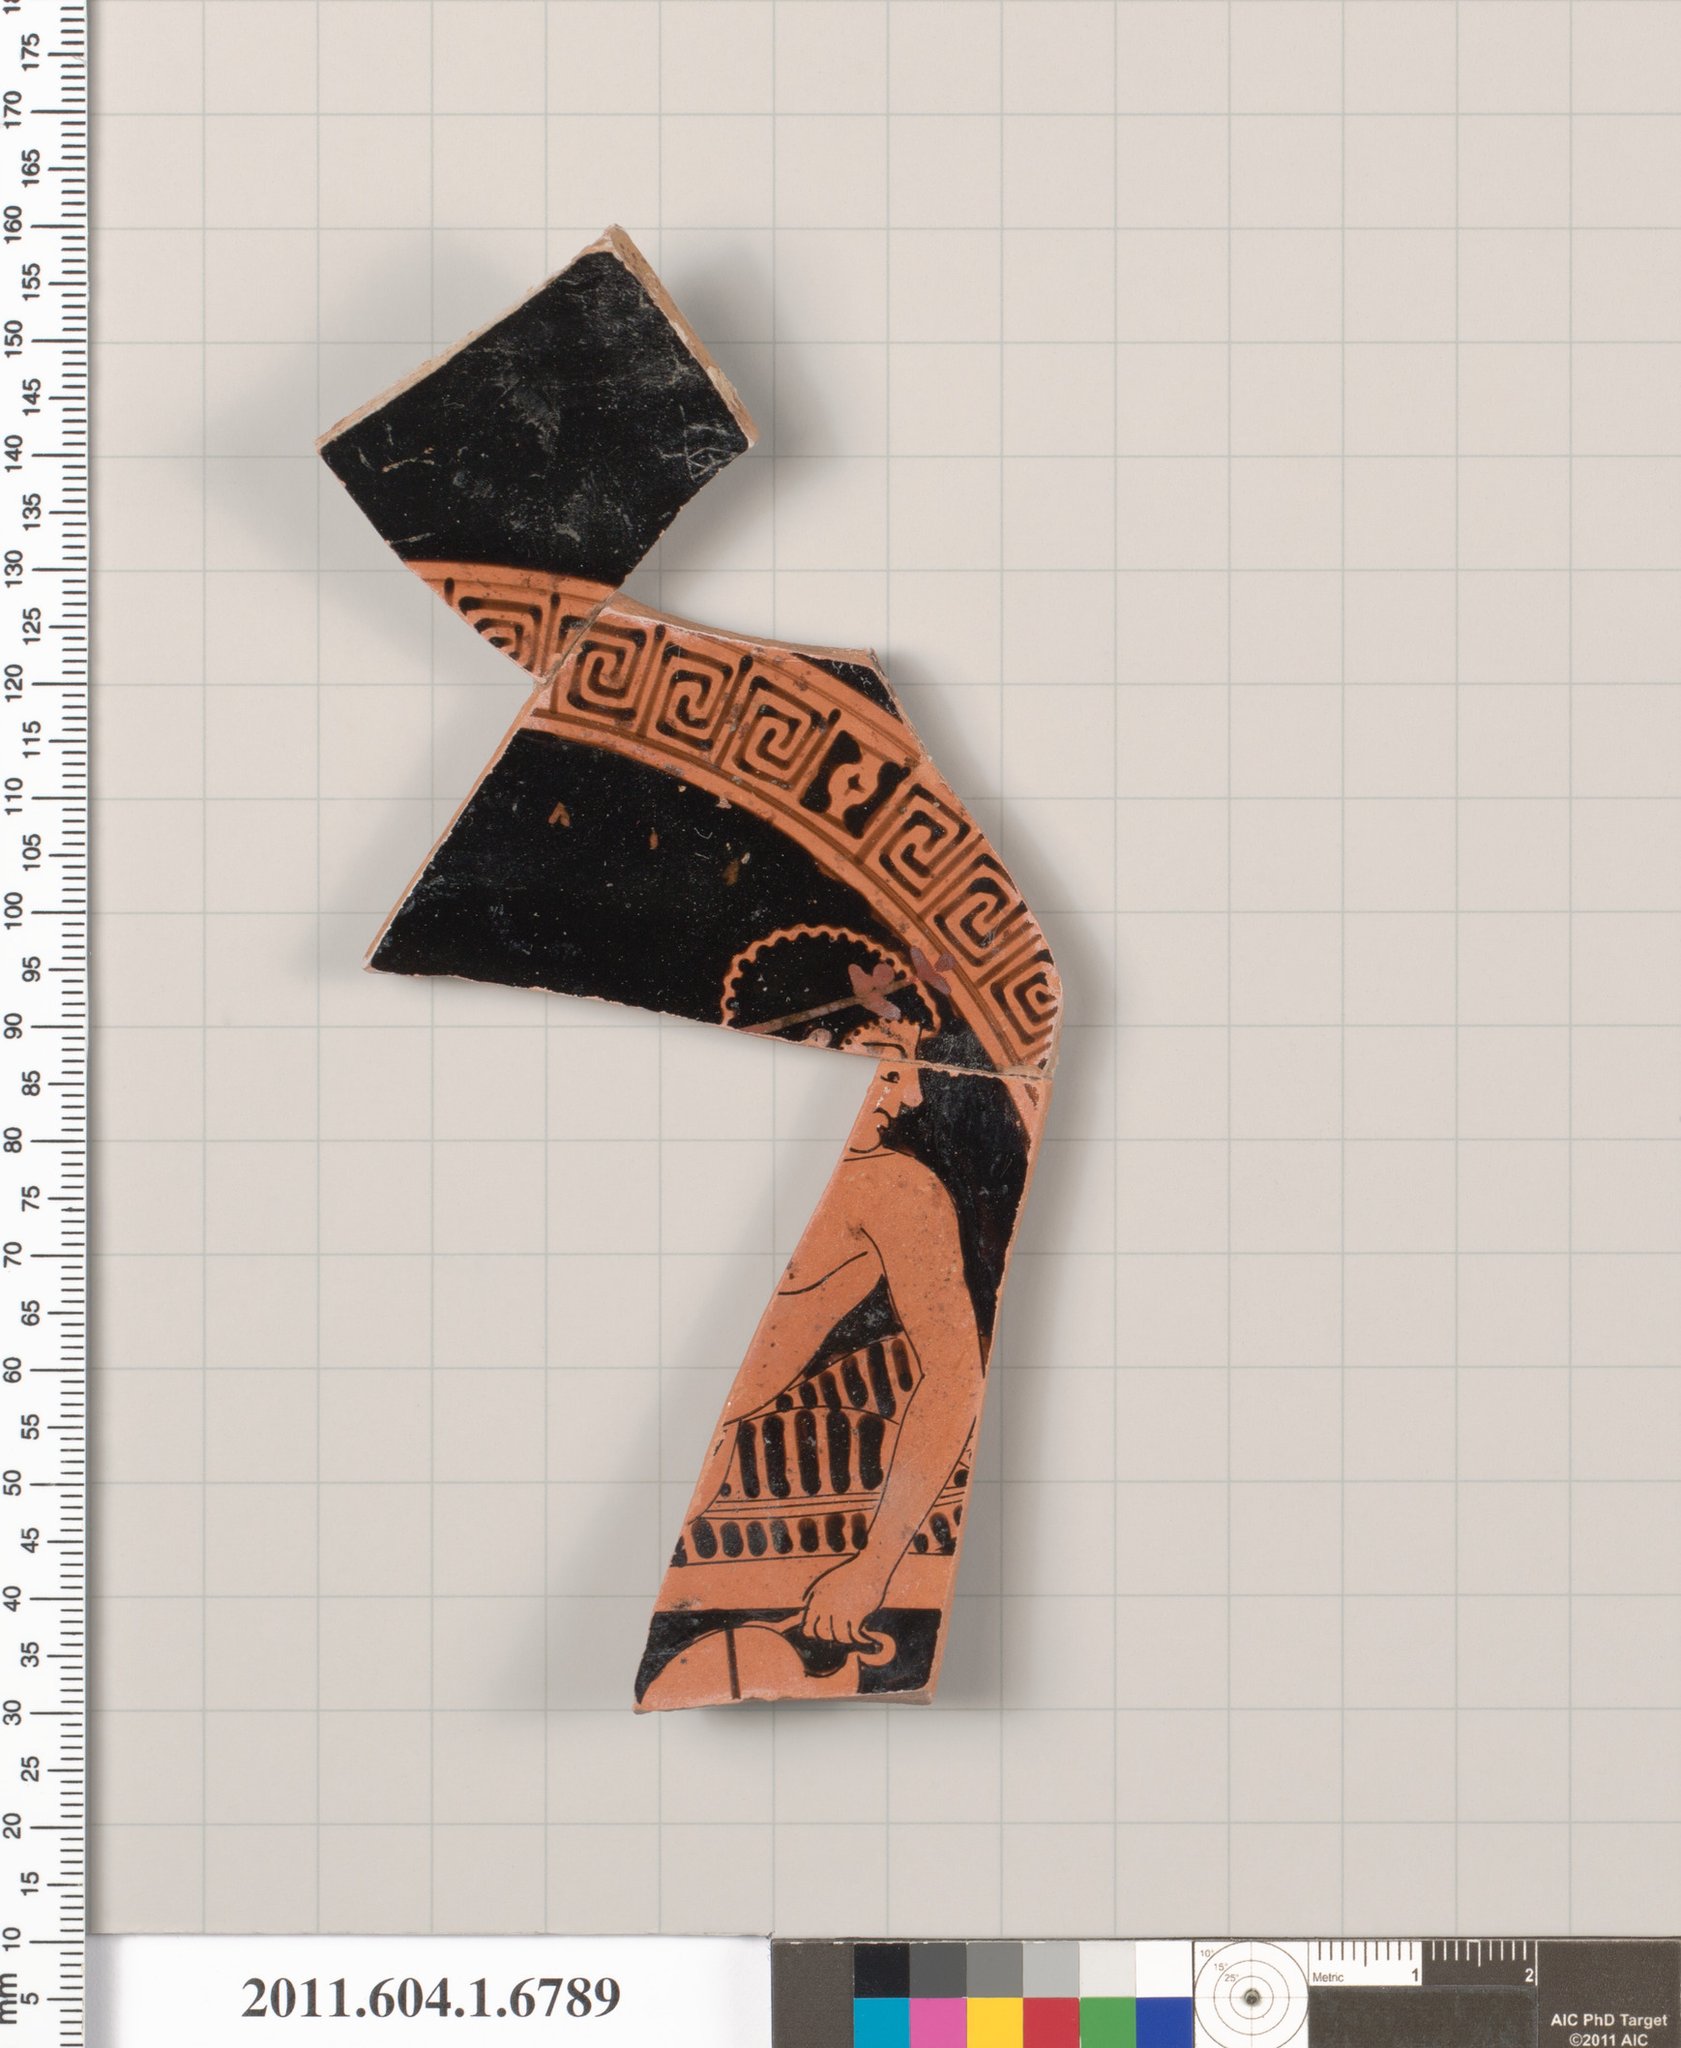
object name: kylix fragment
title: Terracotta fragment of a kylix (drinking cup)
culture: greek, attic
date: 490-470 BCE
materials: terracotta